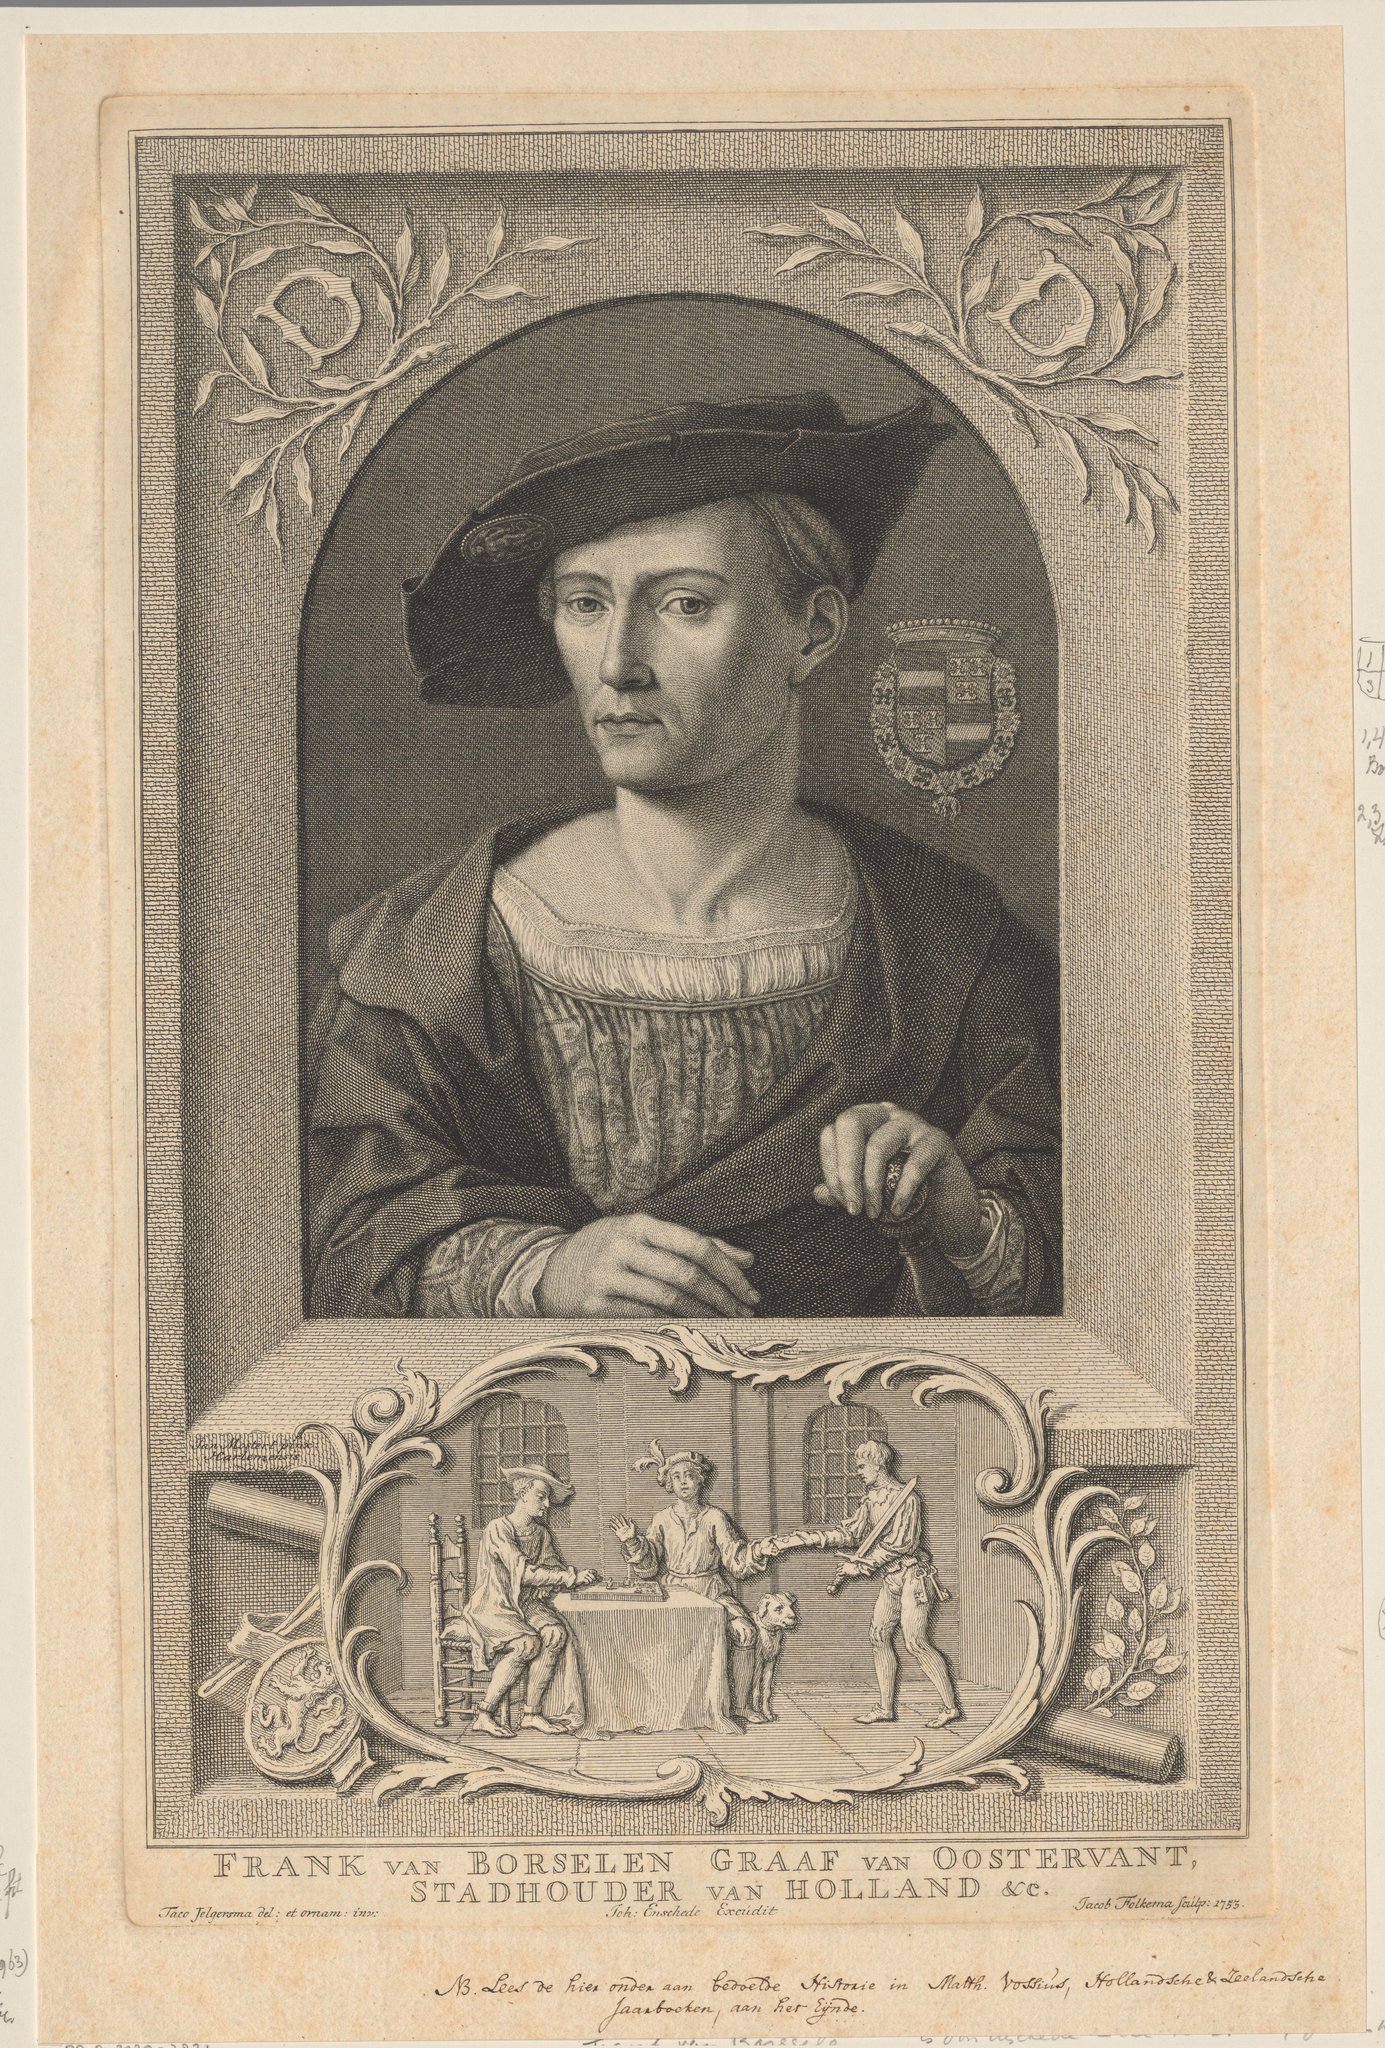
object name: print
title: Portret van Frank van Borselen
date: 1753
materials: paper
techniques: engraving, etching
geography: haarlem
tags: brielle, delivering; receiving (~ postal matter), historical persons, board-games, armorial bearing, heraldry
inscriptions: collector's mark: Lugt 963, inscription: ‘NB lees de hier onder aan bedoelde historie in Matth. Vossius, Hollandsche & Zeelandsche jaarboeken, aan het eijnde.’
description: Met rechts naast het hoofd zijn wapenschild en midden onder een vignet met twee mannen die aan tafel een spel spelen en een derde man die hen een brief overhandigt.